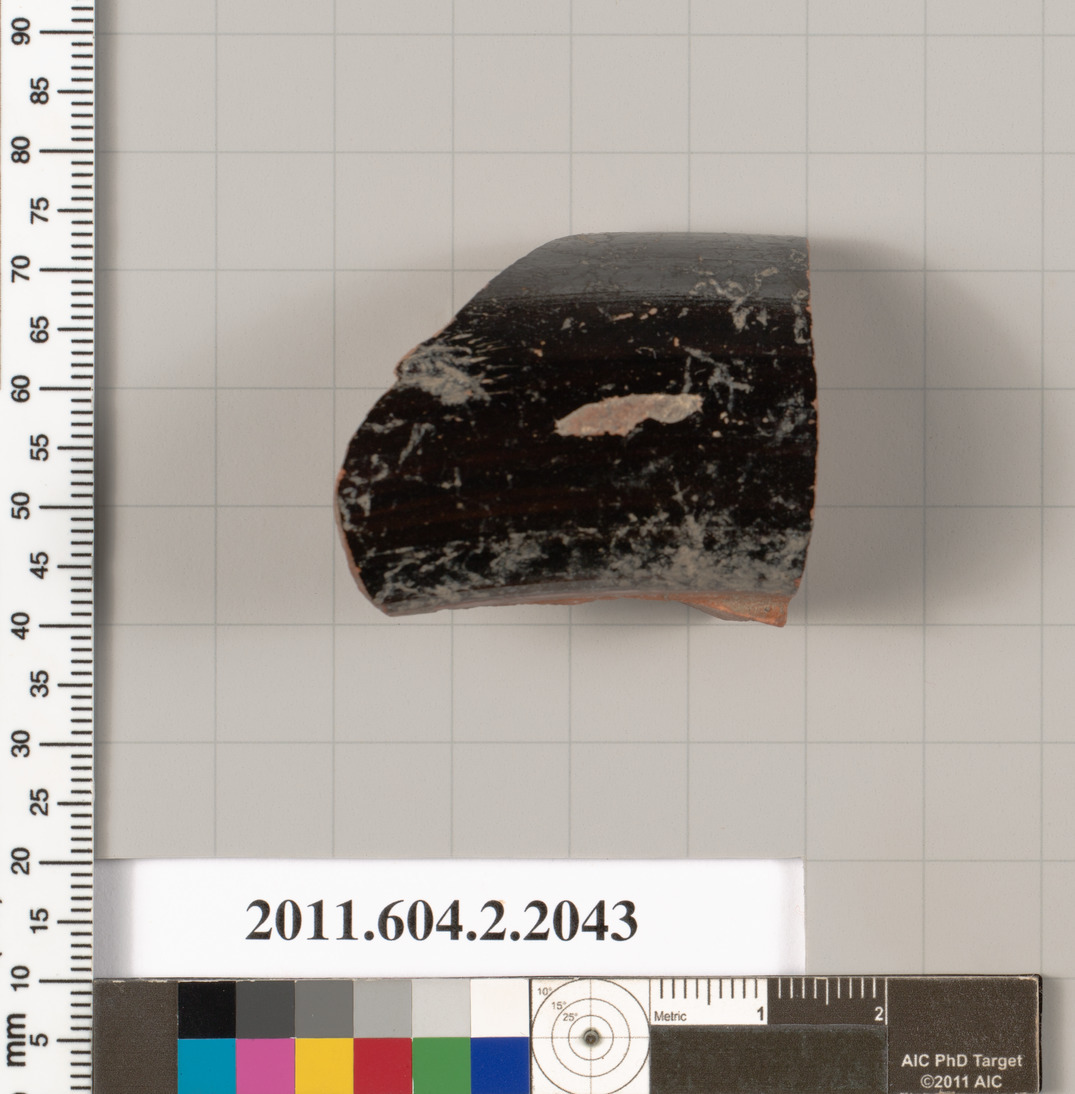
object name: krater fragment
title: Terracotta fragment of a calyx-krater (bowl for mixing wine and water)?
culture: greek, attic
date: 500-451 BCE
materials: terracotta